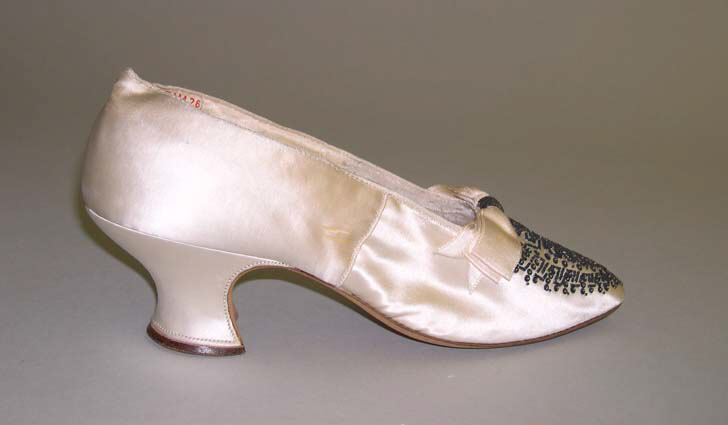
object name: shoe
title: Shoes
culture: french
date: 1890-1899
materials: silk